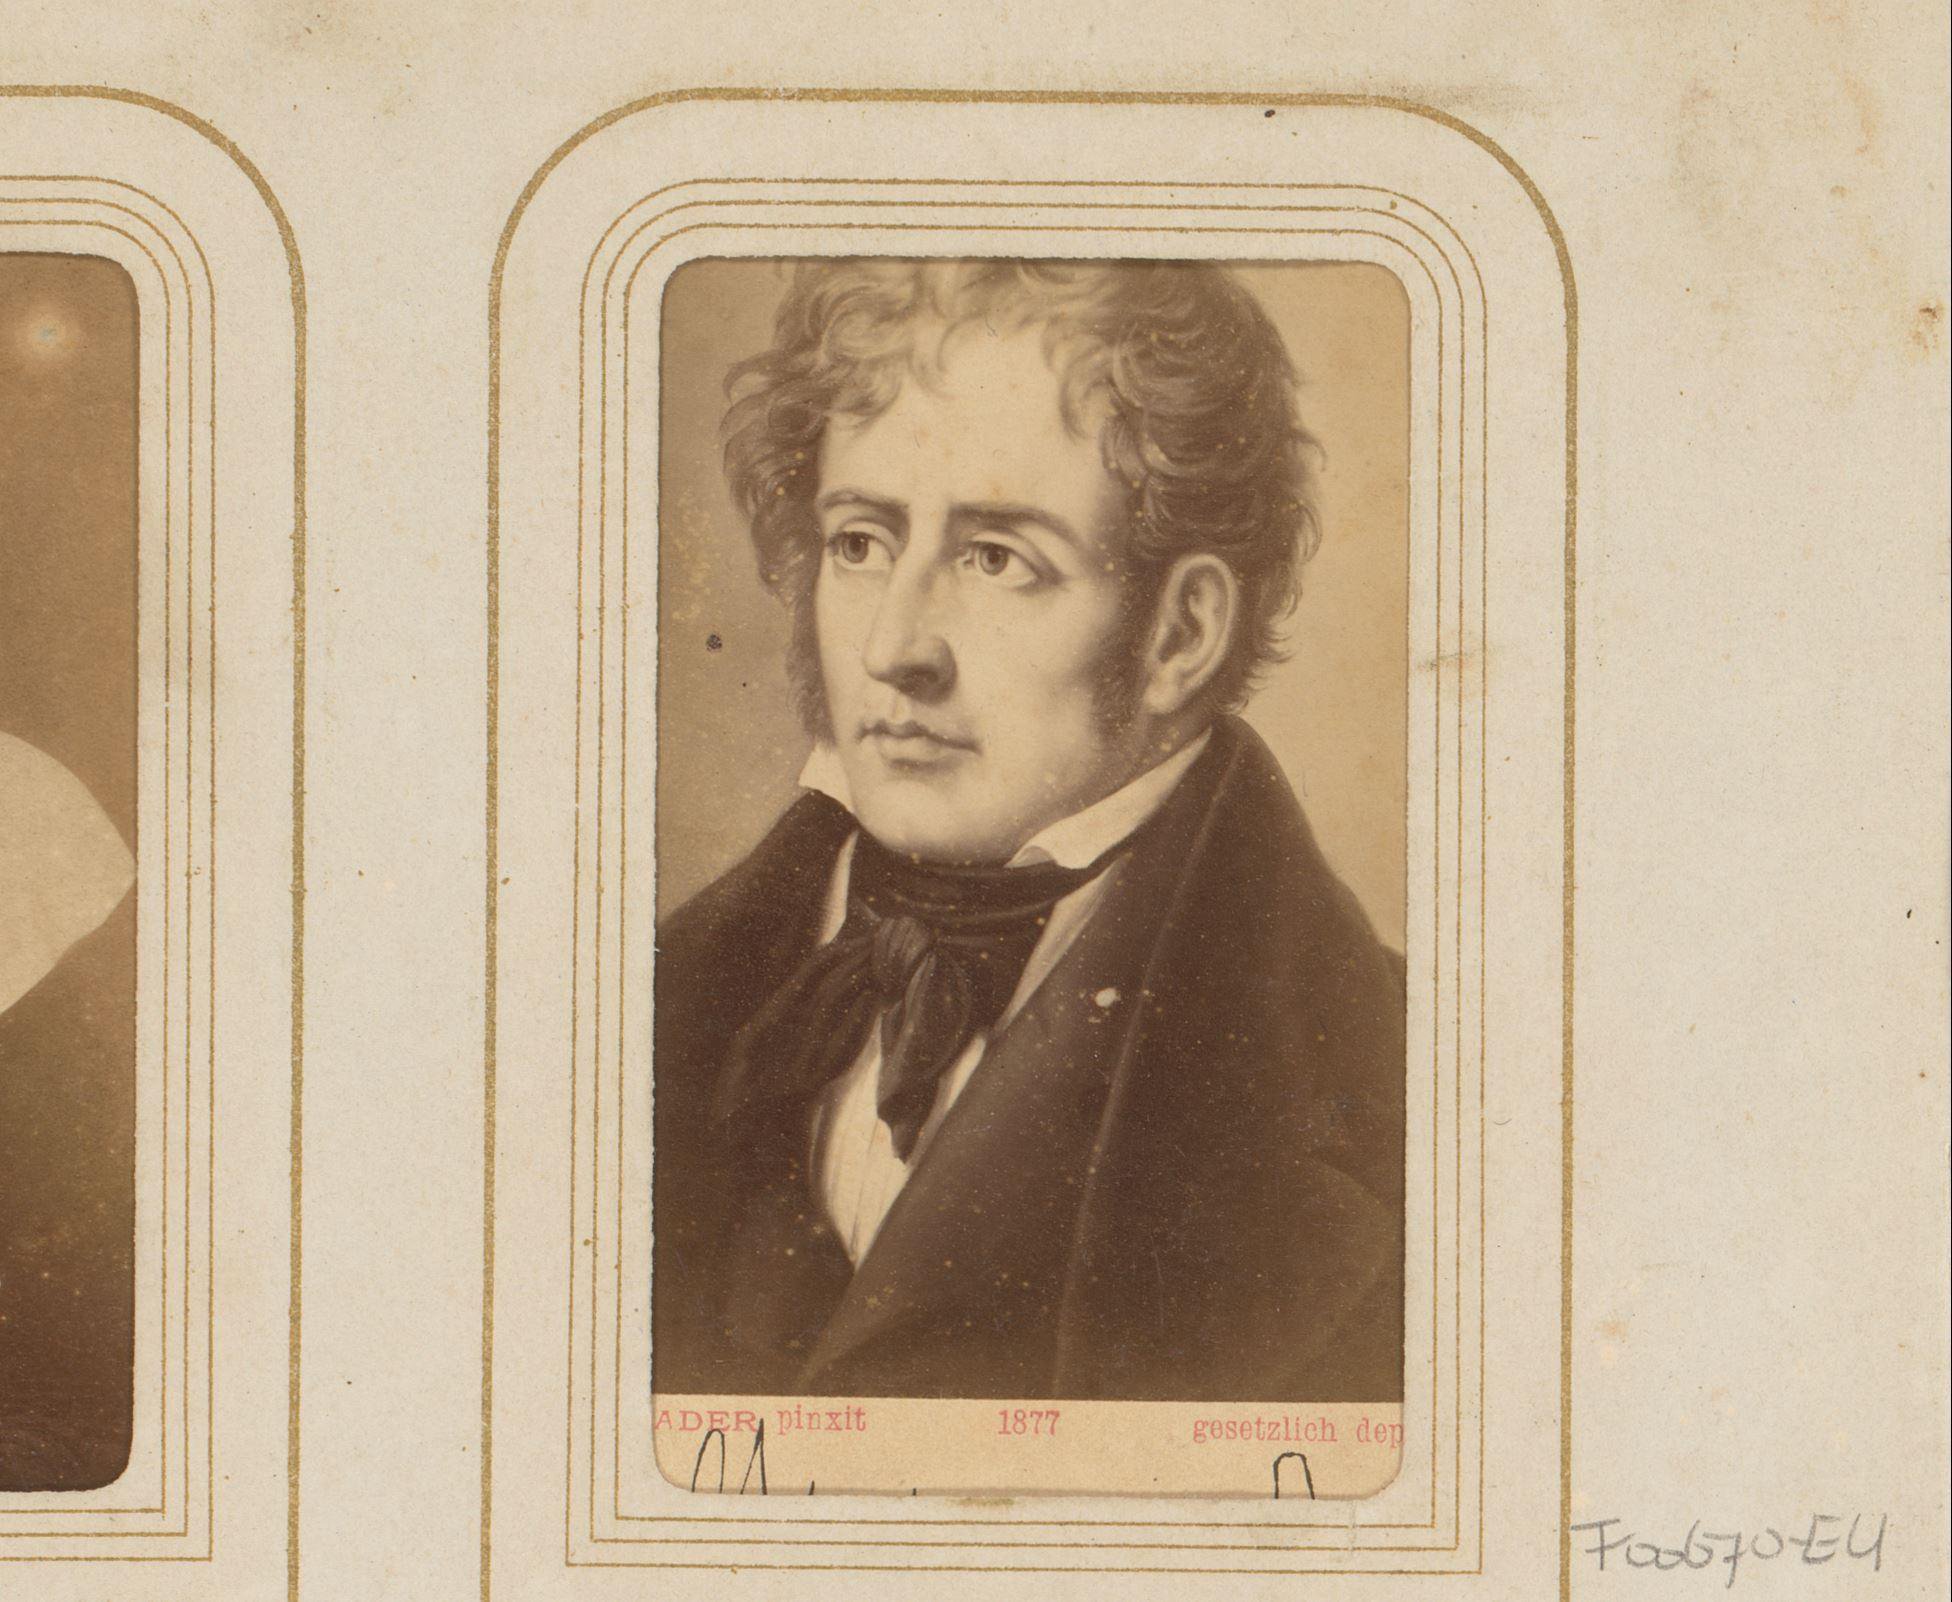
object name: carte de visite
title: Fotoreproductie van een geschilderd portret van François René de Chateaubriand naar Ernst Hader door Sophus Williams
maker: sophus williams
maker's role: publisher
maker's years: 1835-1900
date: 1877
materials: cardboard, photographic support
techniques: albumen print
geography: berlin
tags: paris, politician, françois-rené de chateaubriand, historical persons, writer, poet, author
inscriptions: name: ‘Chateaubriand’, annotation: ‘25/ Chateaubriand’